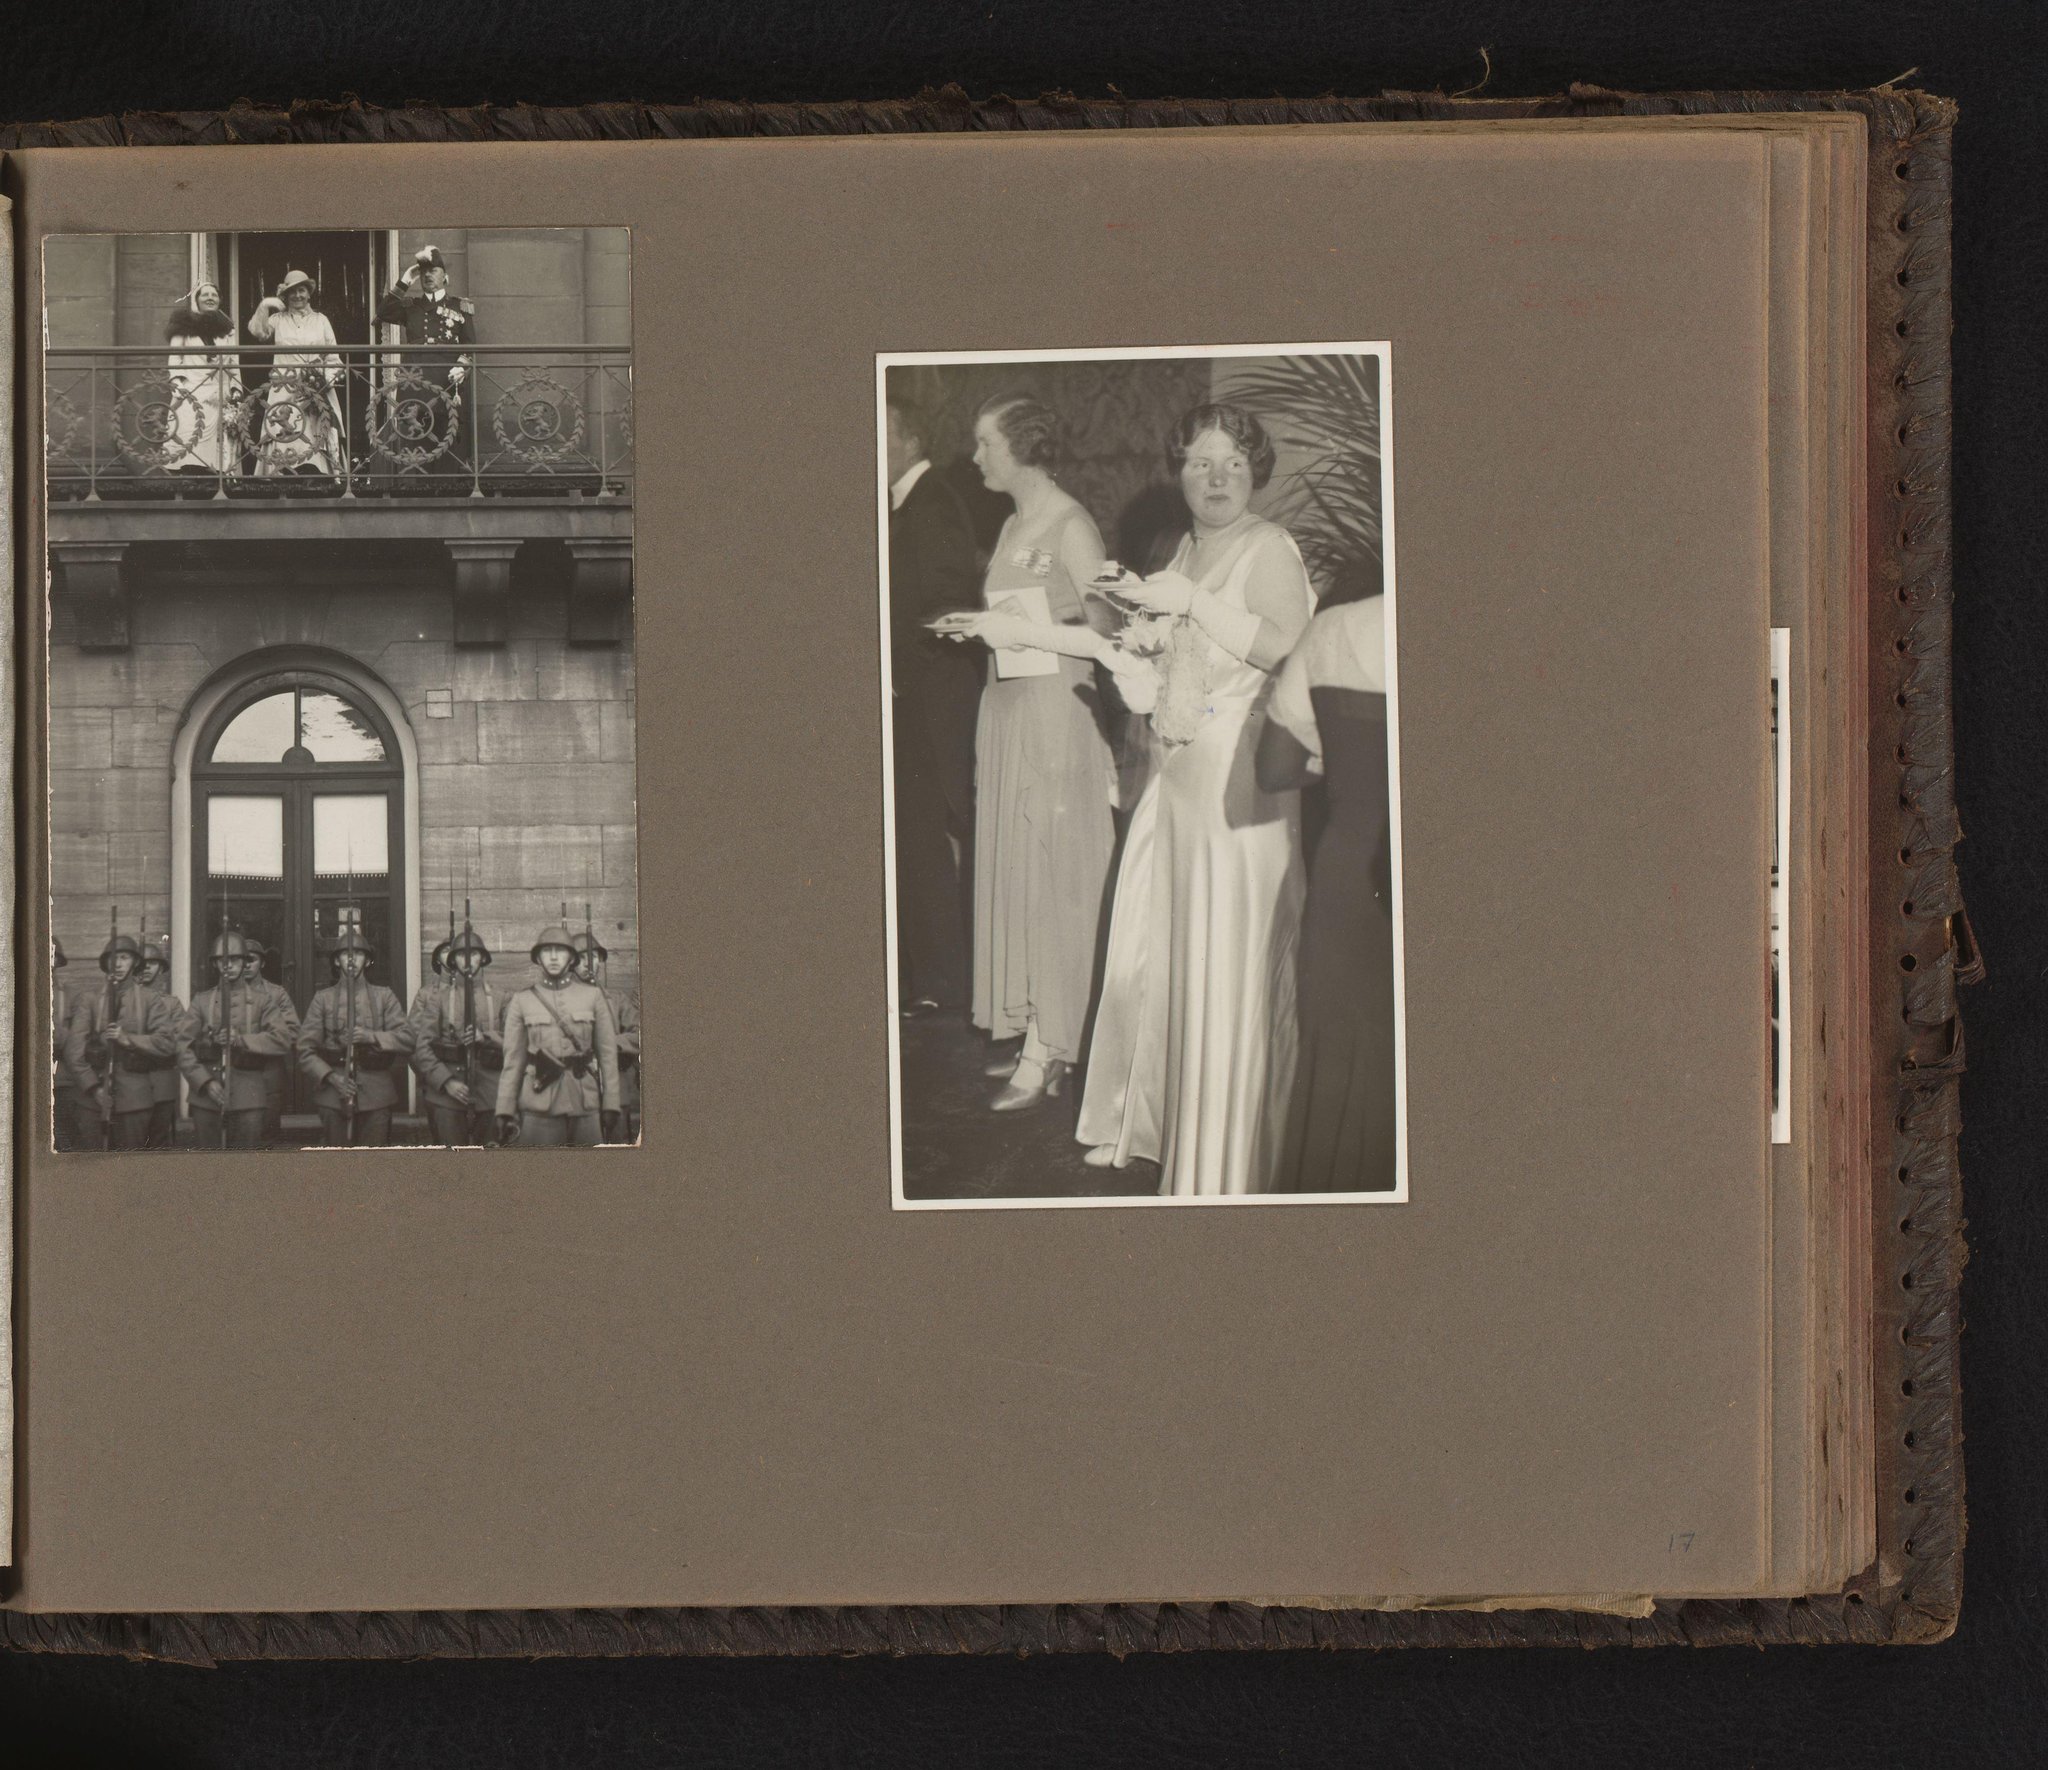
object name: photograph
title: Twee foto's van prinses Juliana, op het balkon van het Paleis op de Dam en bij een banket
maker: Anonymous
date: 1930-1935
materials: paper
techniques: gelatin silver print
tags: the hague, juliana of the netherlands, adult woman, royal palace of amsterdam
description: Deze foto's maken deel uit van een album.